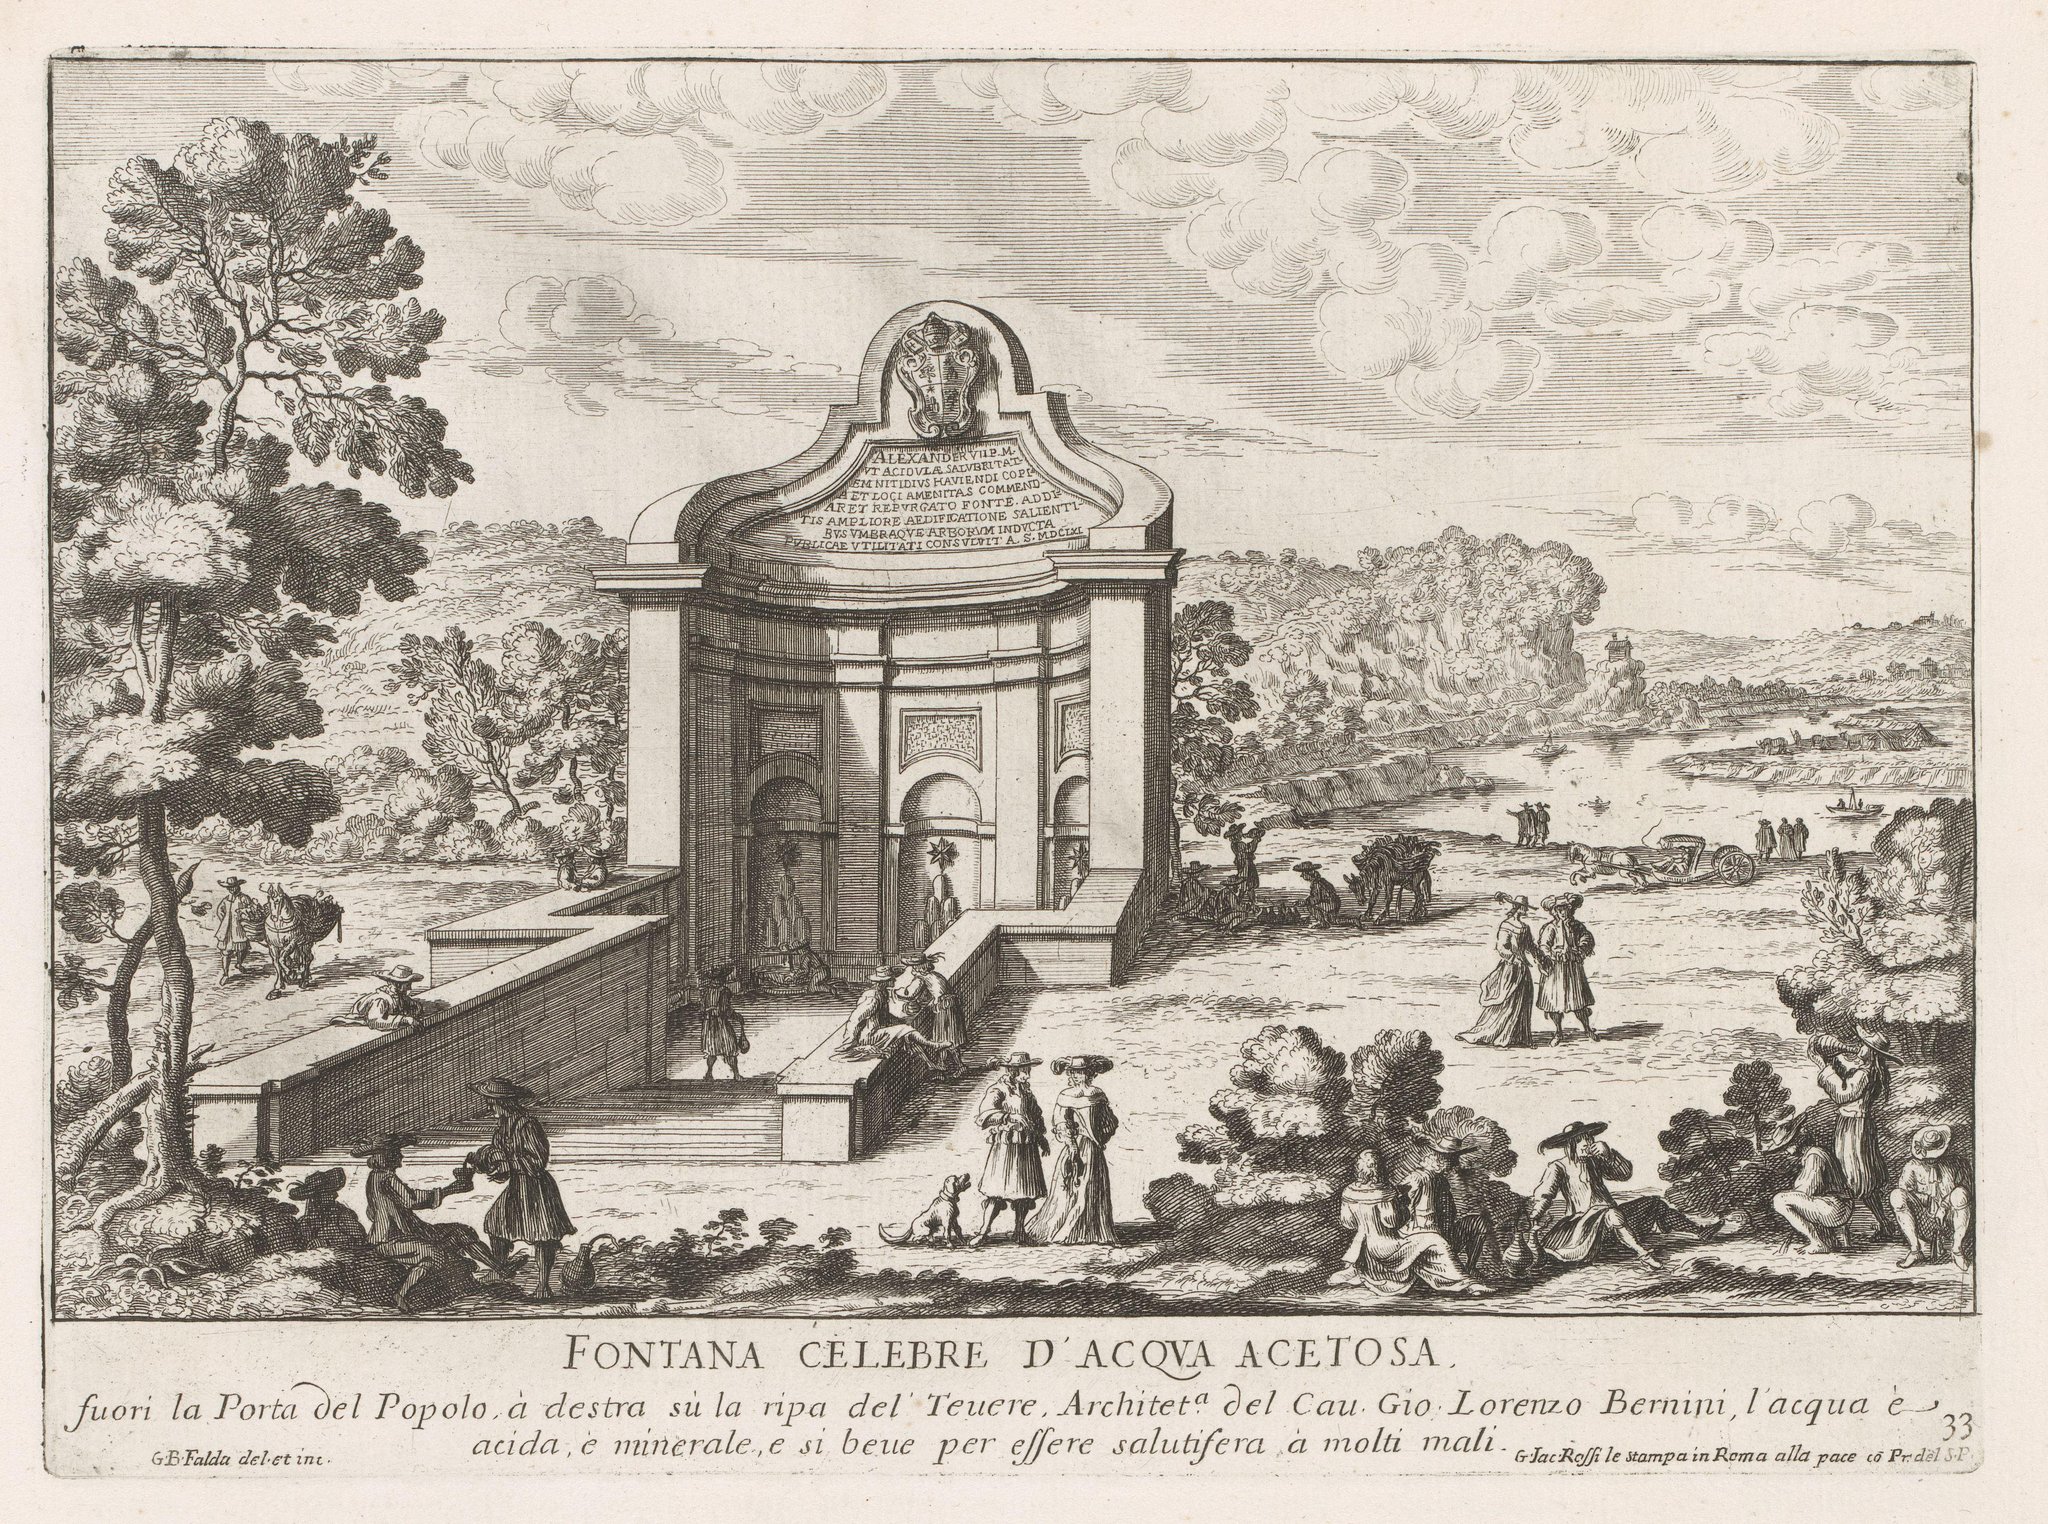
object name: album leaf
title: Fontane di Roma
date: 1653-1691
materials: paper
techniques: etching, intaglio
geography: vatican city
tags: ornamental fountain, rome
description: Landschap met de Fontana dell'Acqua Acetosa te Rome. Genummerd rechtsonder: 33. De prent maakt deel uit van een album.